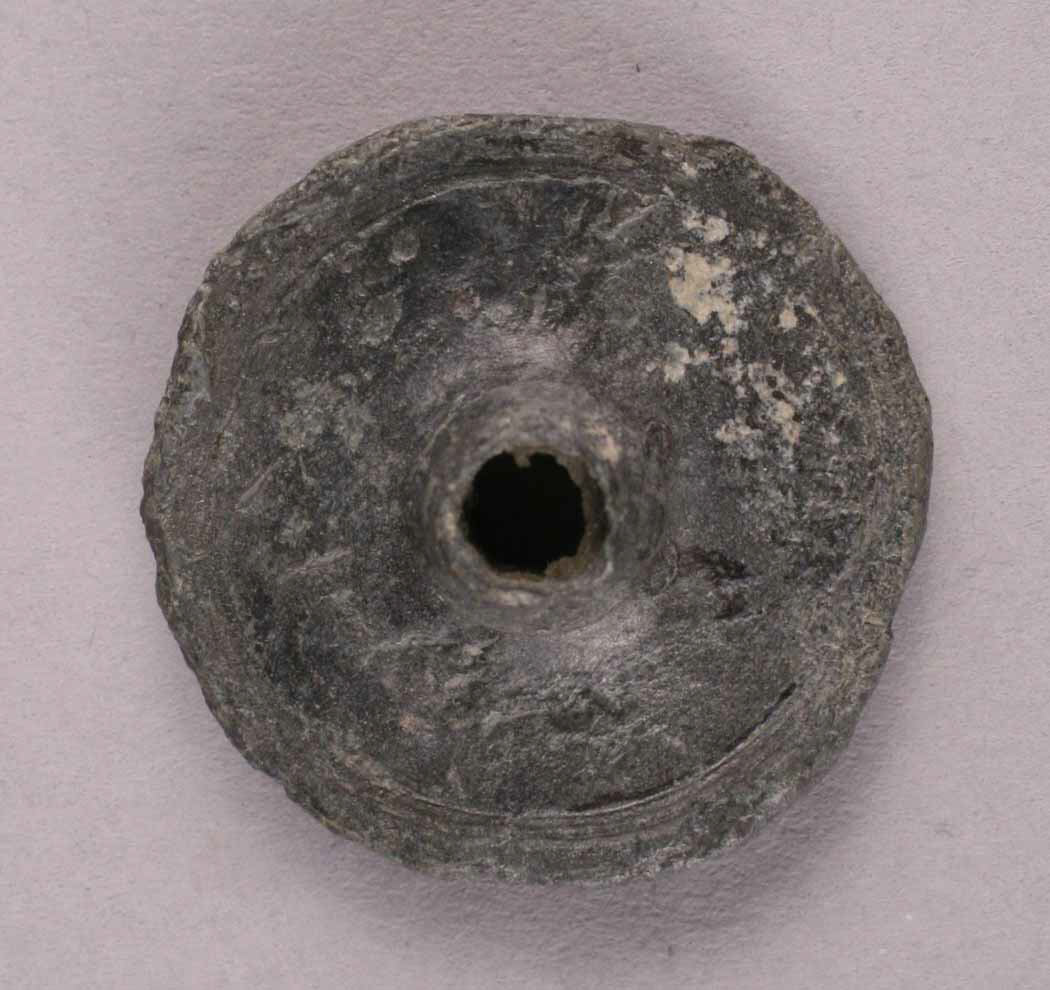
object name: weight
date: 801-1000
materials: lead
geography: iran